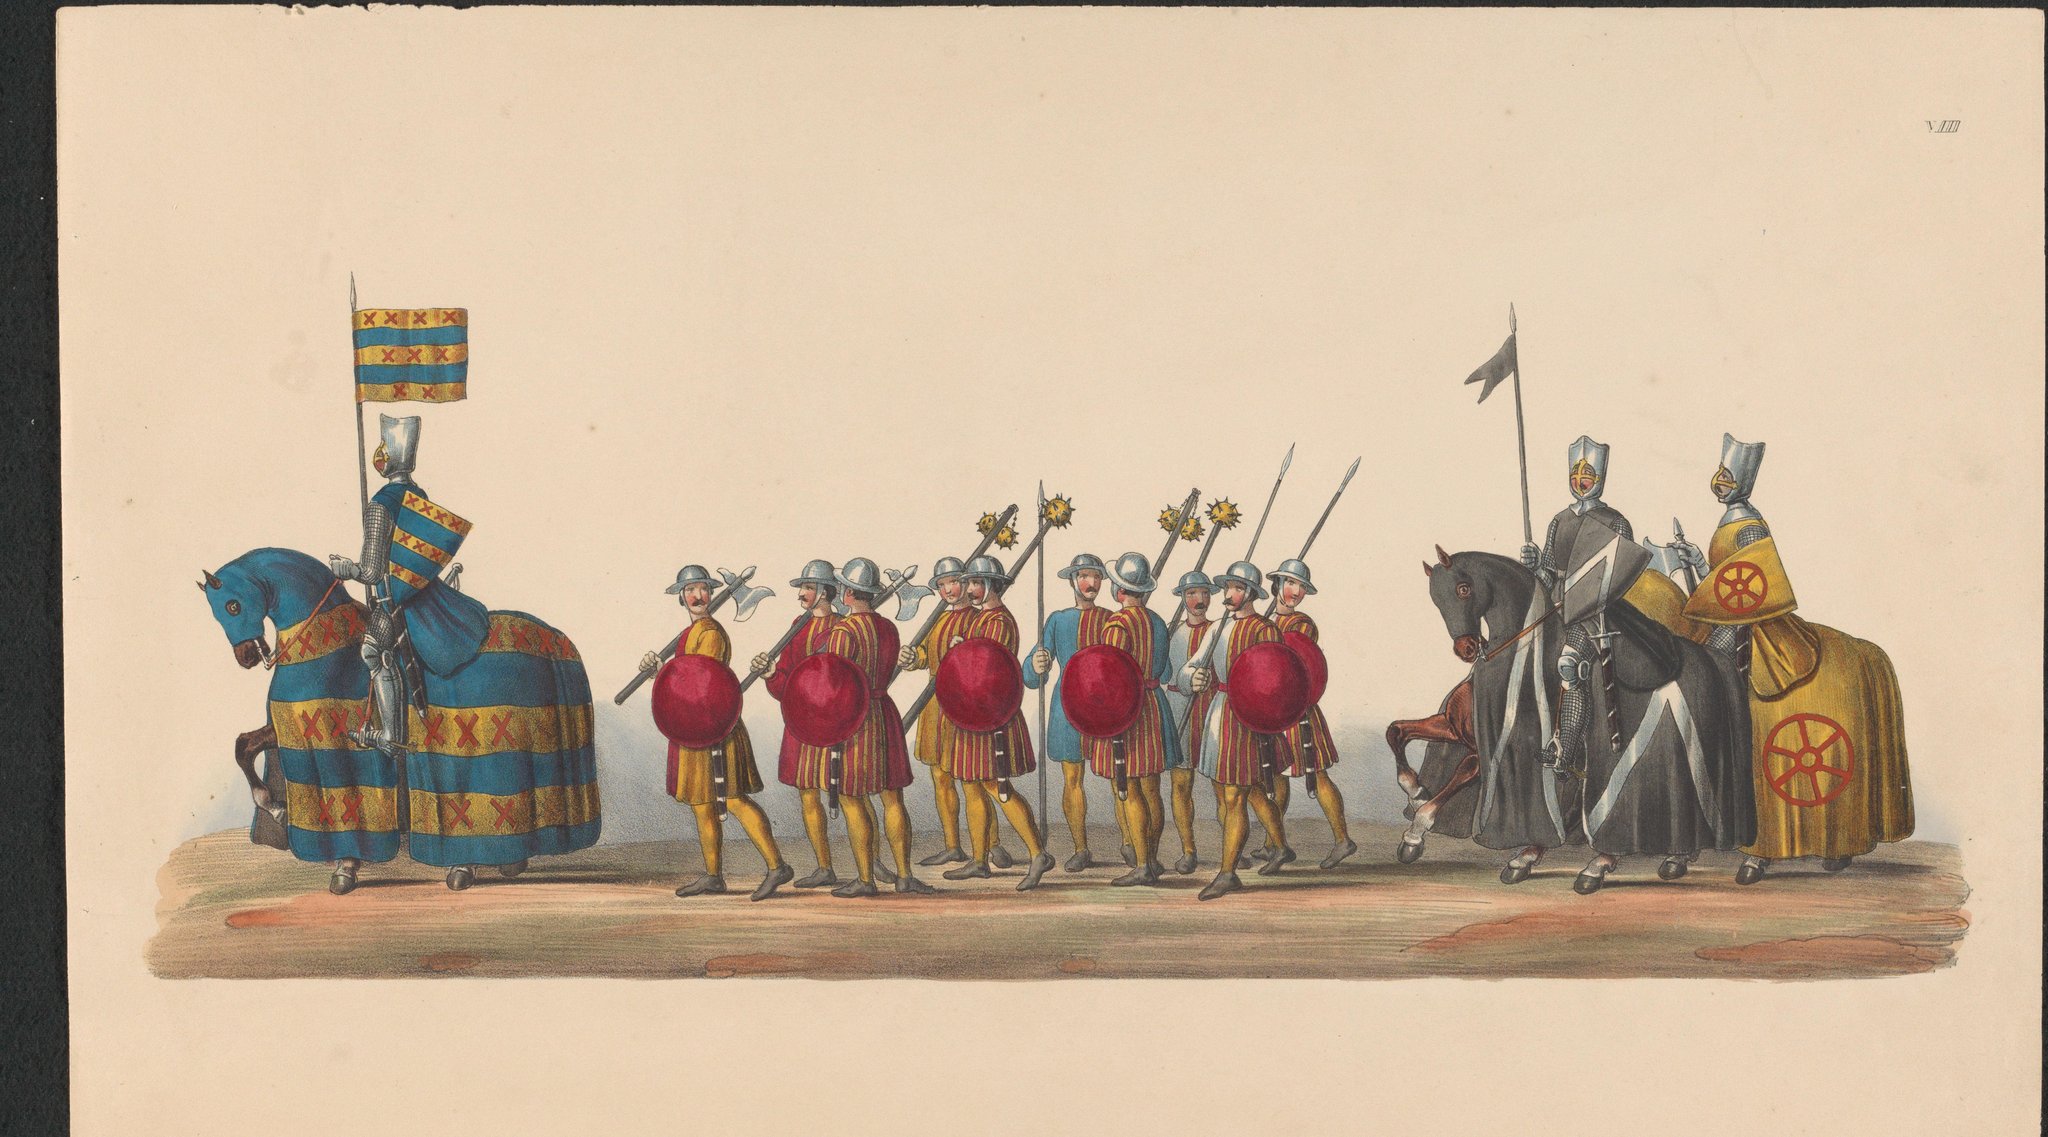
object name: print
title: Gecostumeerde Optogt. Voorstellende de ontvangst van Willem II Graaf van Holland Roomsch Koning binnen Utrecht in Januarij 1249 gegeven door HH Studenten ter viering van het 25ste Jaar van de Herstelling der Utrechtsche Hoogeschool den 2e Junij 1841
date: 1841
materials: paper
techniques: hand coloring, lithograph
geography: utrecht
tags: students' pageant, costumes used in pageants, utrecht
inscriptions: collector's mark: Lugt 2228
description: Drie ridders in wapenrusting te paard, tussen hen in een groep voetsoldaten. Blad genummerd VIII in de serie van achttien platen van de historische gekostumeerde optocht voorstellende de ontvangst van graaf Willem II van Holland in Utrecht in 1249. De optocht gehouden door de studenten van de Universiteit van Utrecht op 2 juni 1841 ter gelegenheid van de viering van het vijfentwintigjarige herstel van de Hogeschool.